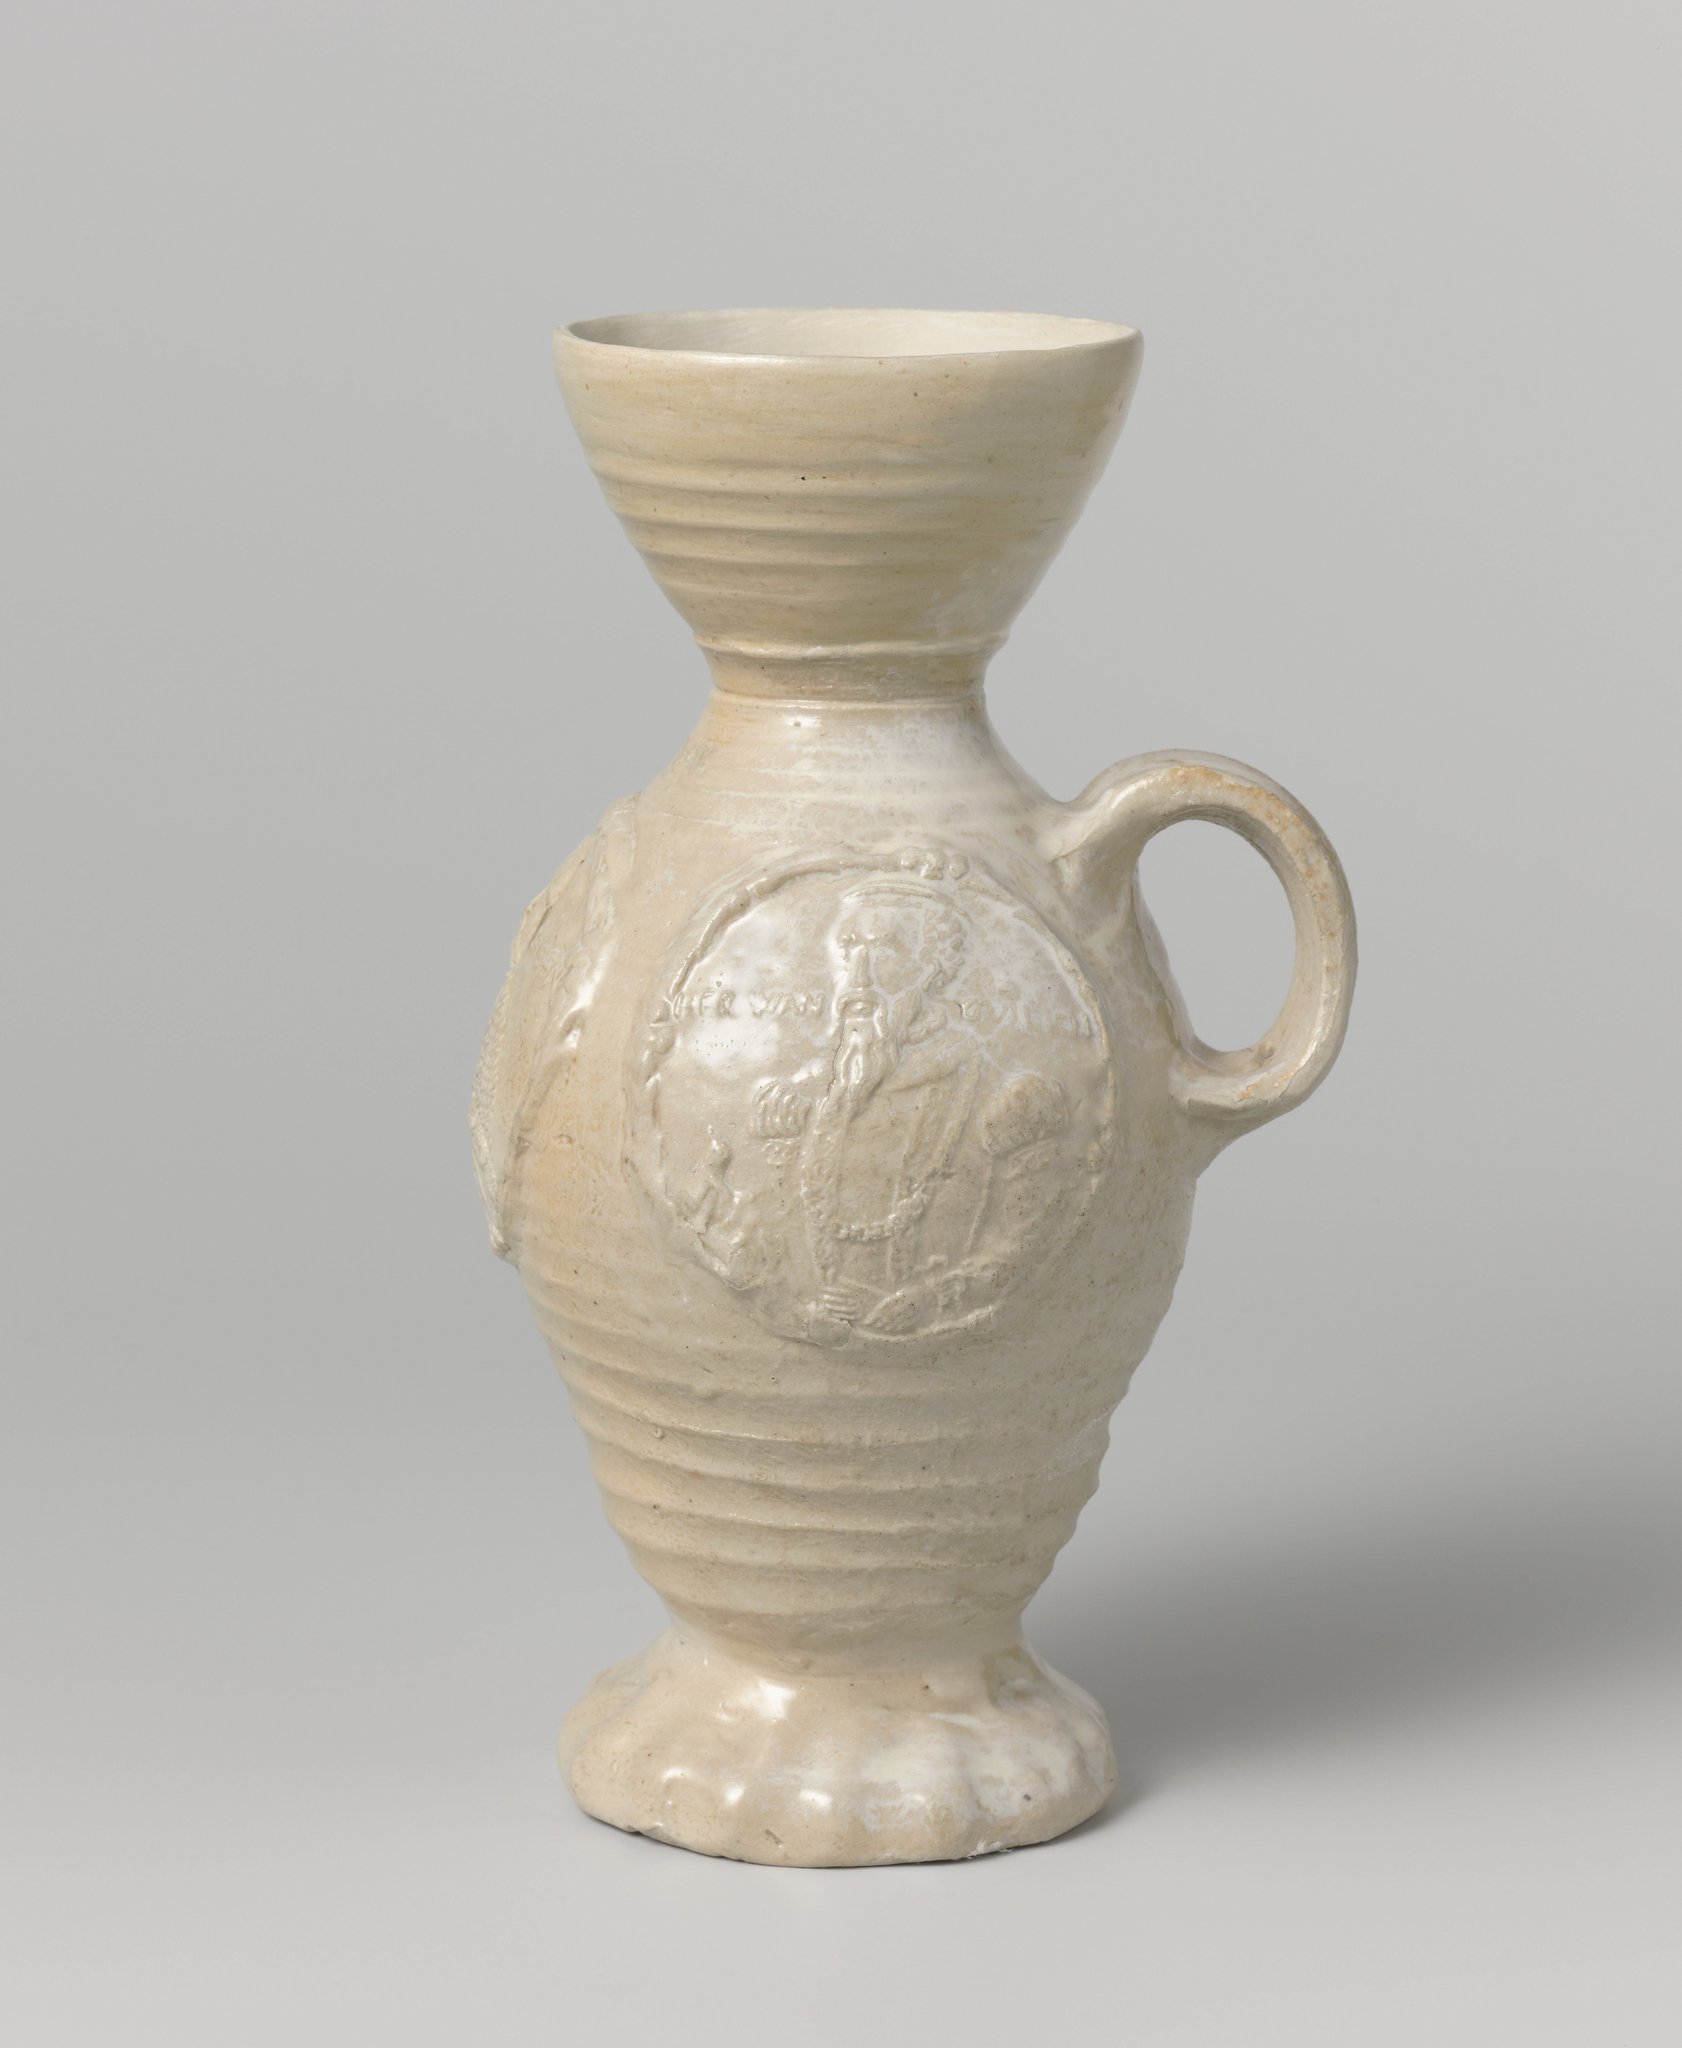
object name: cup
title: Funnel-necked jug (<Trichterhalskrug>) with medallions with Charles V and the Dukes of Saxony and Jülich-Cleve-Berg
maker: Anonymous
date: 1550-1599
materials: glaze, stoneware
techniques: firing, forming, relief, turning, vitrification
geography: siegburg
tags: hertog, willem v (hertog van gulik, kleef en berg, graaf van mark en ravensberg)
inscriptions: inscription: ‘CAROL LVS/ HER SO SASEN/ HER WAN GVILICH’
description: Beker (trechterhalsbeker) van steengoed op golvende voet met een eivormig lichaam en trechtervormige nek. Het C-vormige oor is bevestigd aan de schouder. De beker is versierd met draairingen en op de buik in reliëf driemaal een gedrukt en opgelegd medaillon met protretten van Karel V, 'CAROLVS', de hertog van Saksen, 'HER SO SASEN', en de hertog van Gulik, Kleef en Berg, 'HER WAN GVILICH'. Siegburg.